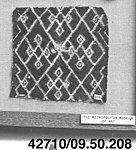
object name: costume fragment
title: Peasant costume fragment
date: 1701-1900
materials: canvas, wool